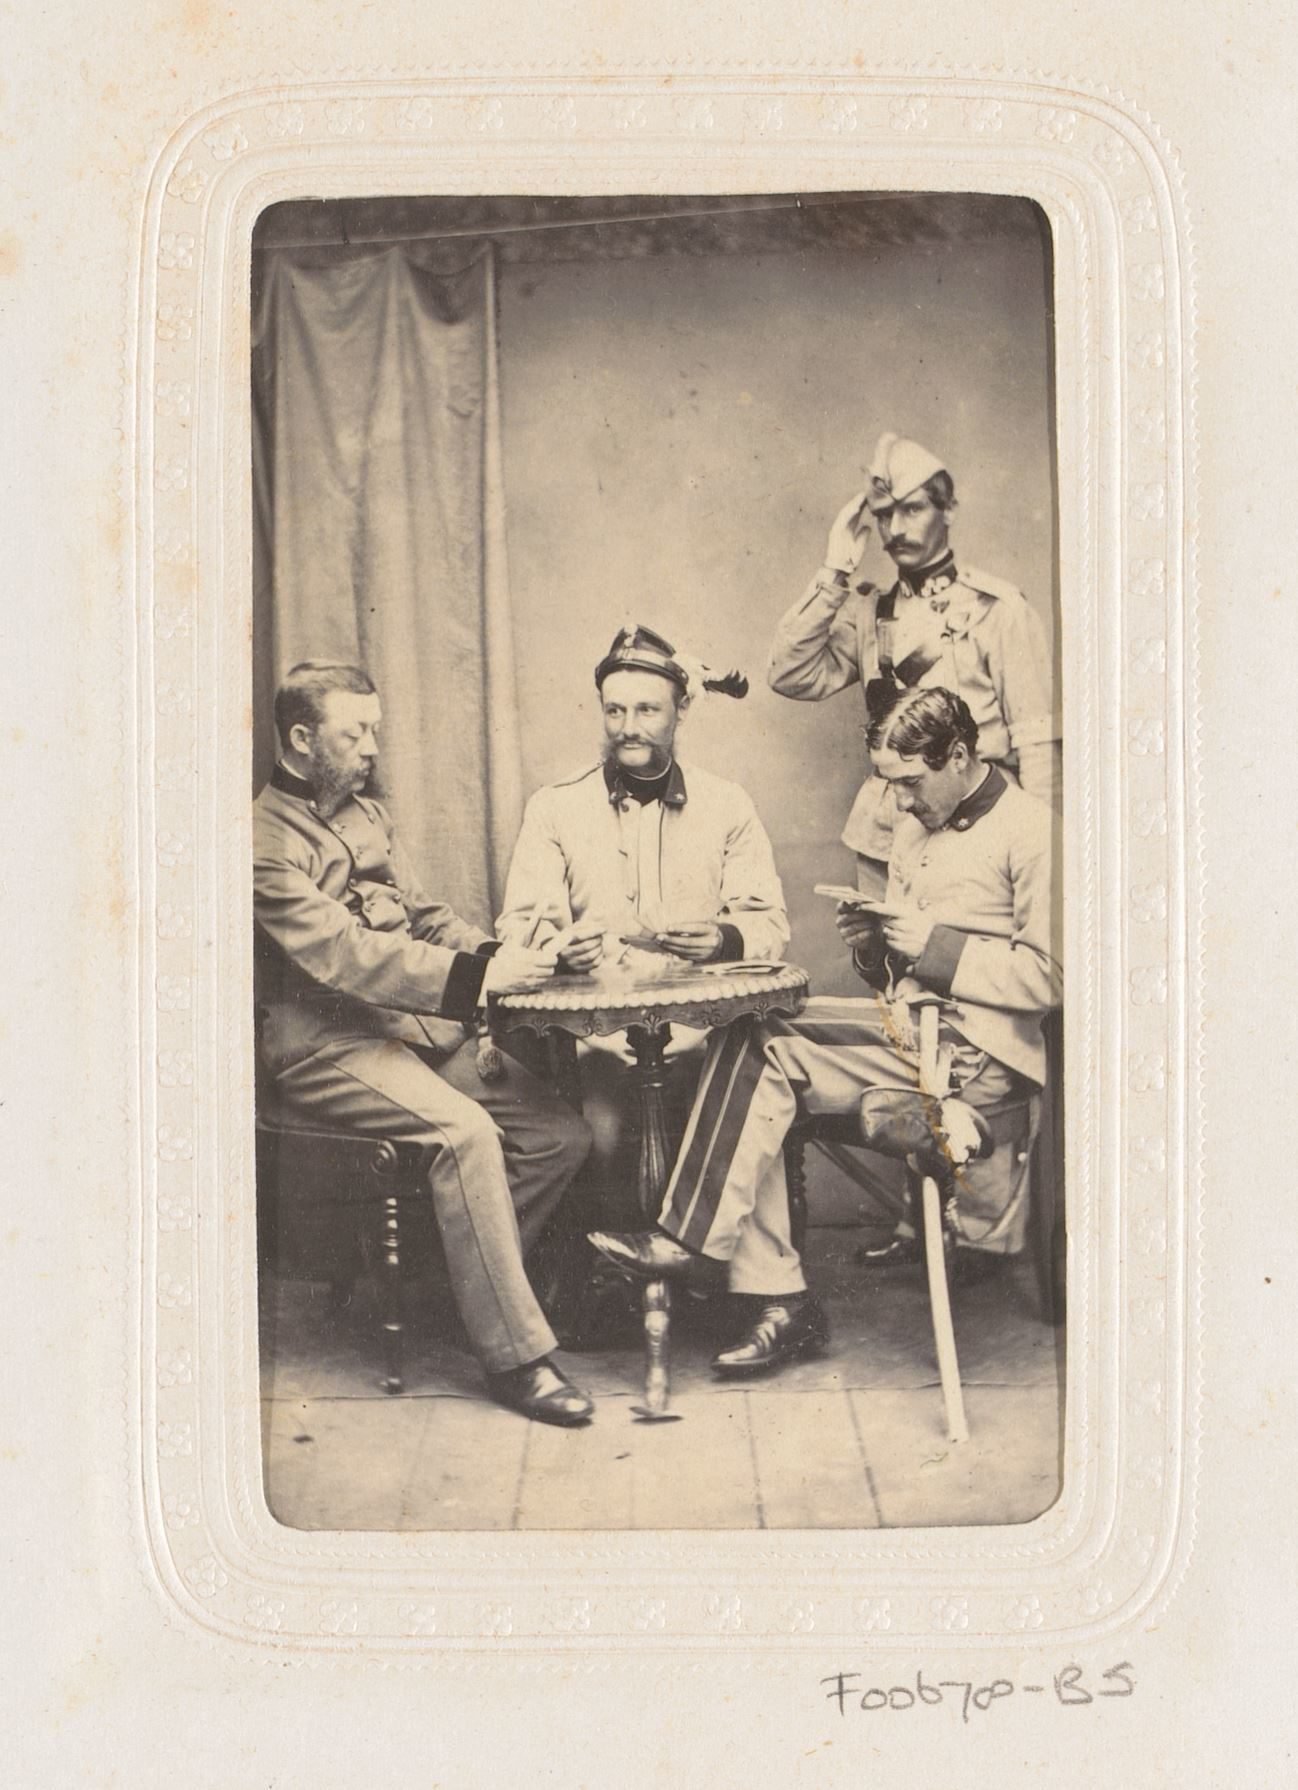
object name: album leaf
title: Portret van vier zittende militairen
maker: Anonymous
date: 1860-1880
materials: cardboard, photographic support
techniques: albumen print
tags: historical persons, (military) uniforms